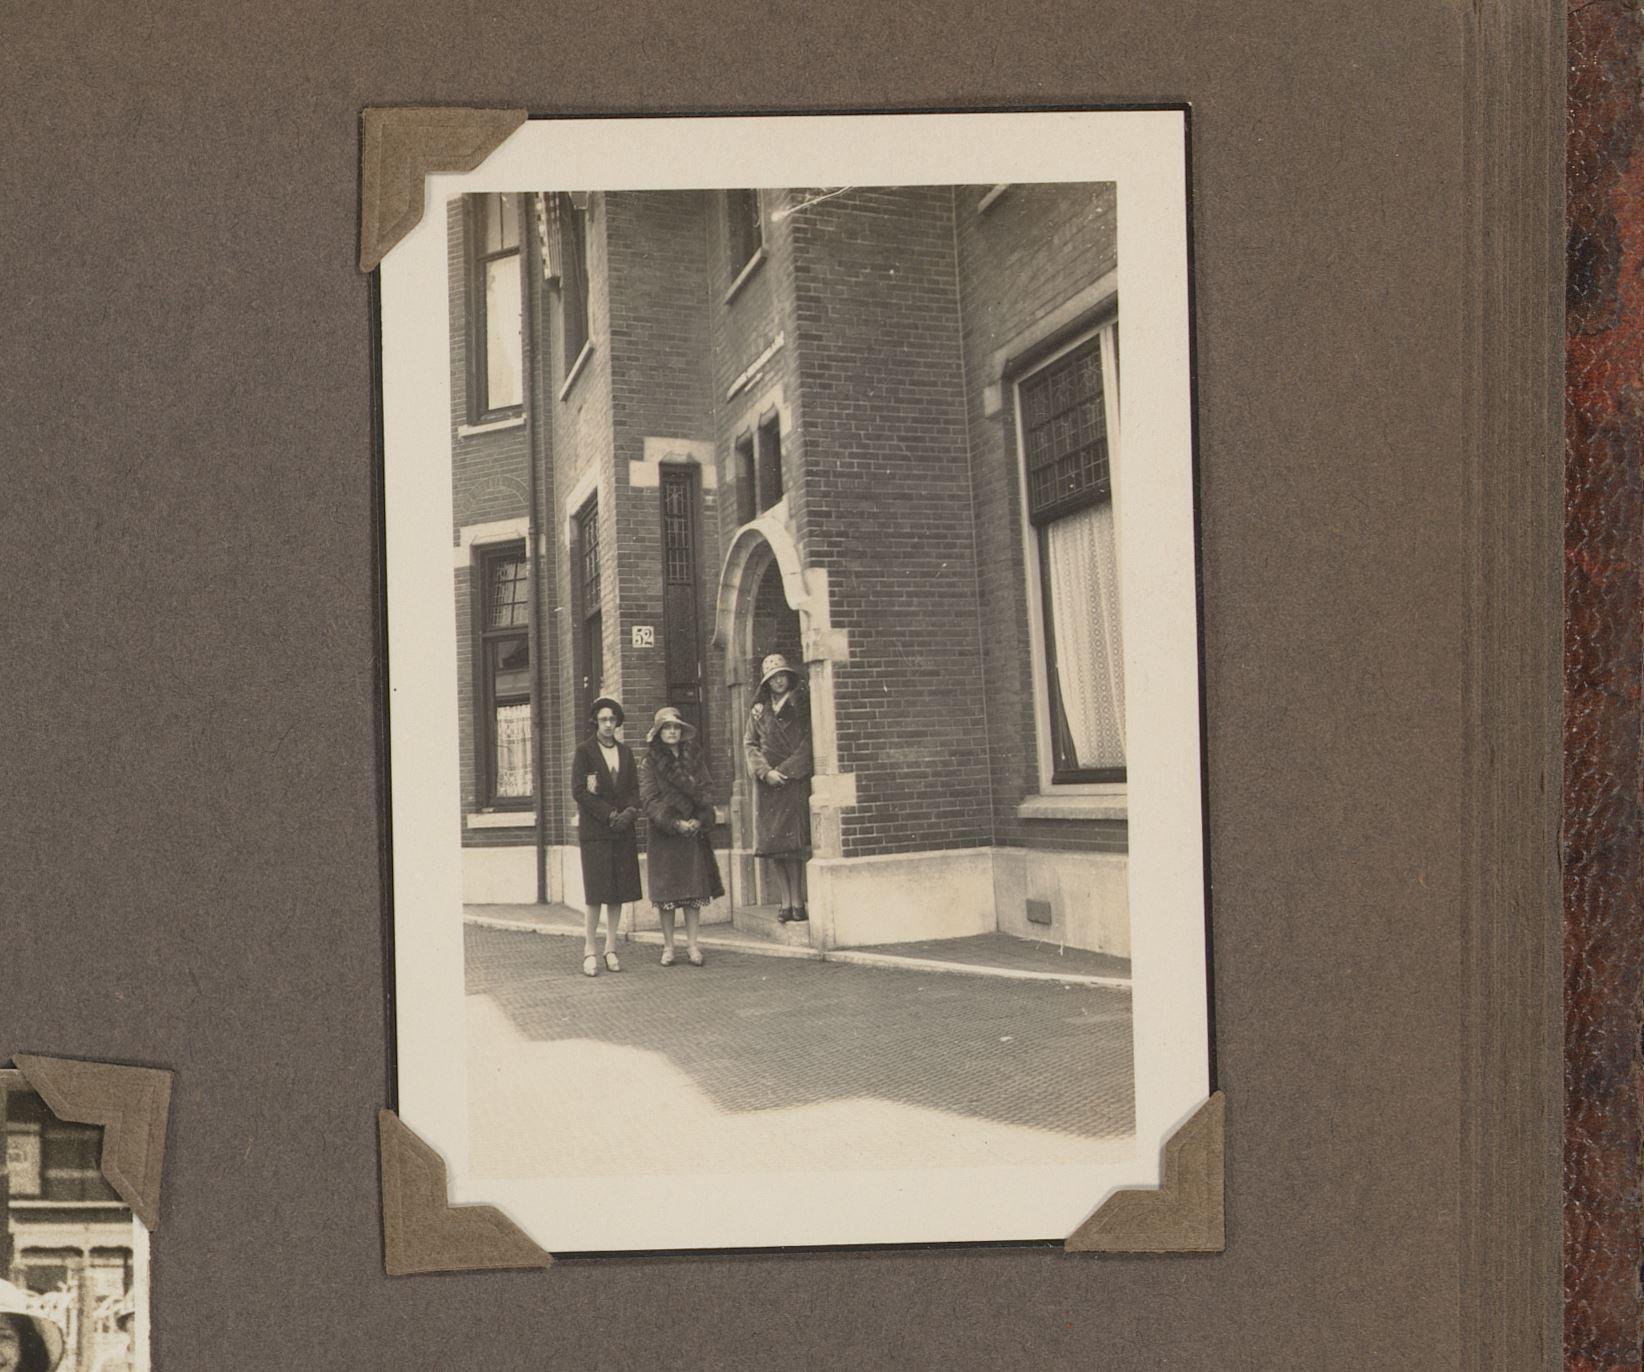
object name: photograph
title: Henriëtte Wassink met haar dochters Dootje en Wilhelmina van Zijll de Jong voor het huis aan de Frederik Hendriklaan 52, Den Haag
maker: Anonymous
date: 1930-1935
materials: paper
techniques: gelatin silver print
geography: the hague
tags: batavia, the hague, henriëtte wassink, amsterdam, wilhelmina van zijll de jong, urban housing, historical persons - bb - woman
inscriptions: number: ‘42 1/4’